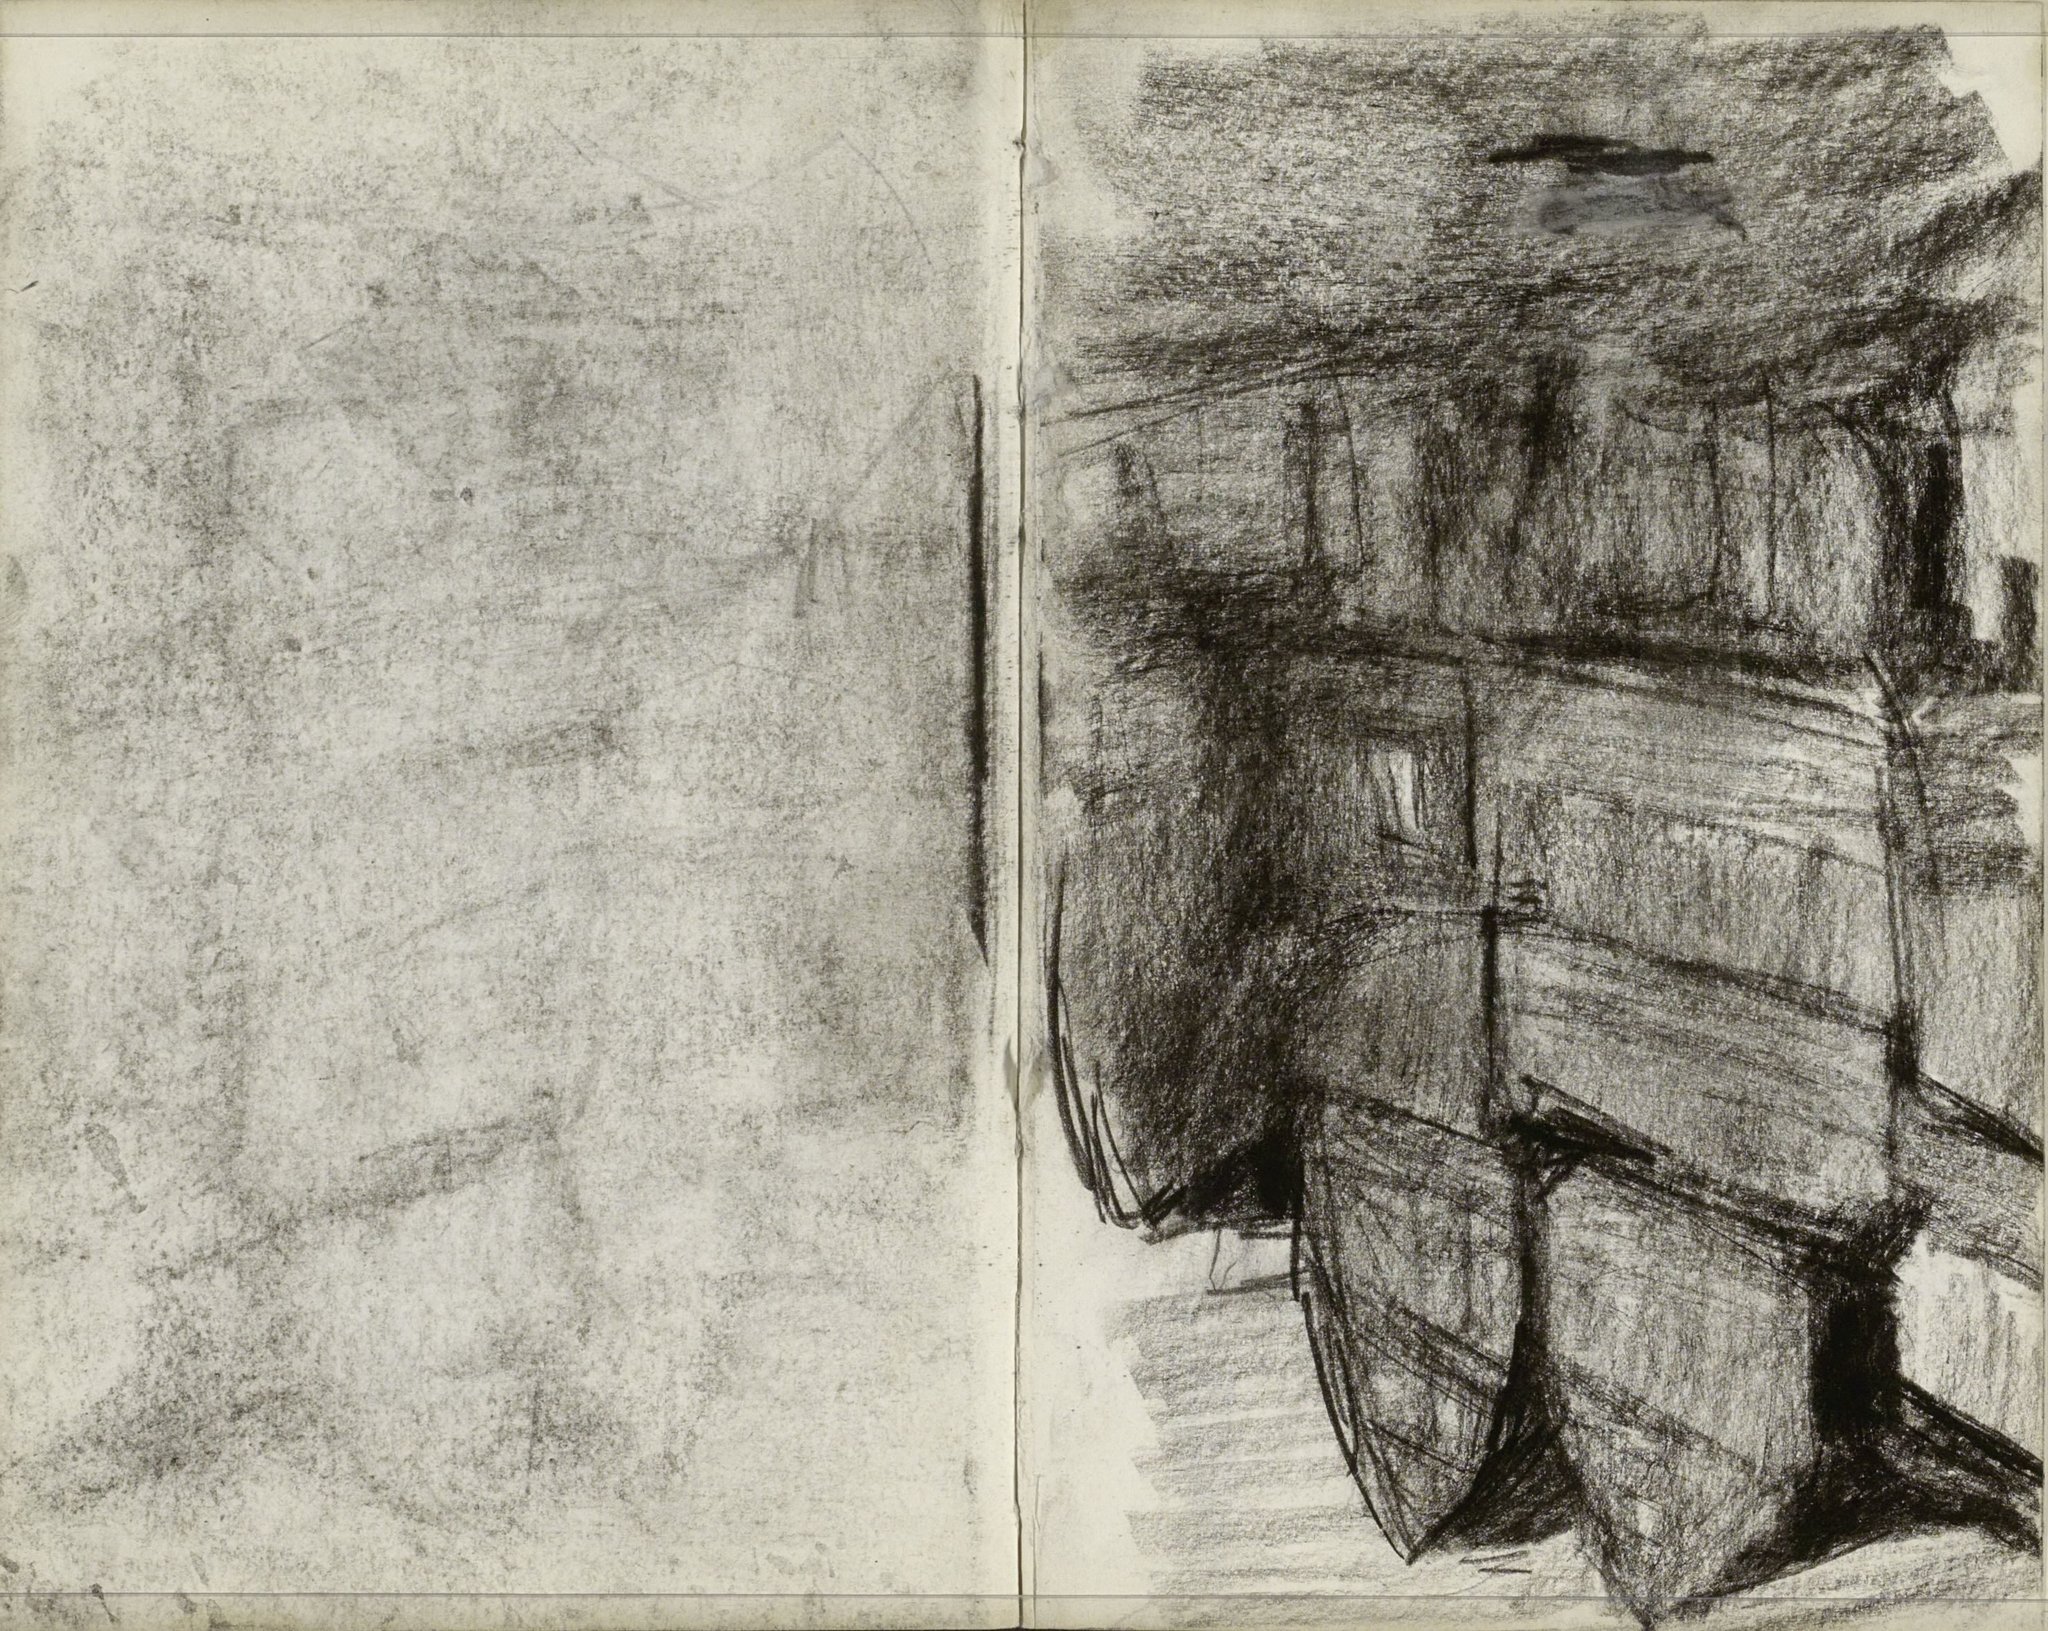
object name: sketchbook leaf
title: Huizenrij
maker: isaac israels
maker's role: draughtsman, painter, print maker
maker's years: 1865-1934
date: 1875-1934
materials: chalk, paper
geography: london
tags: urban housing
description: Blad 4 verso en blad 5 recto uit schetsboek XXXVI met 26 bladen.